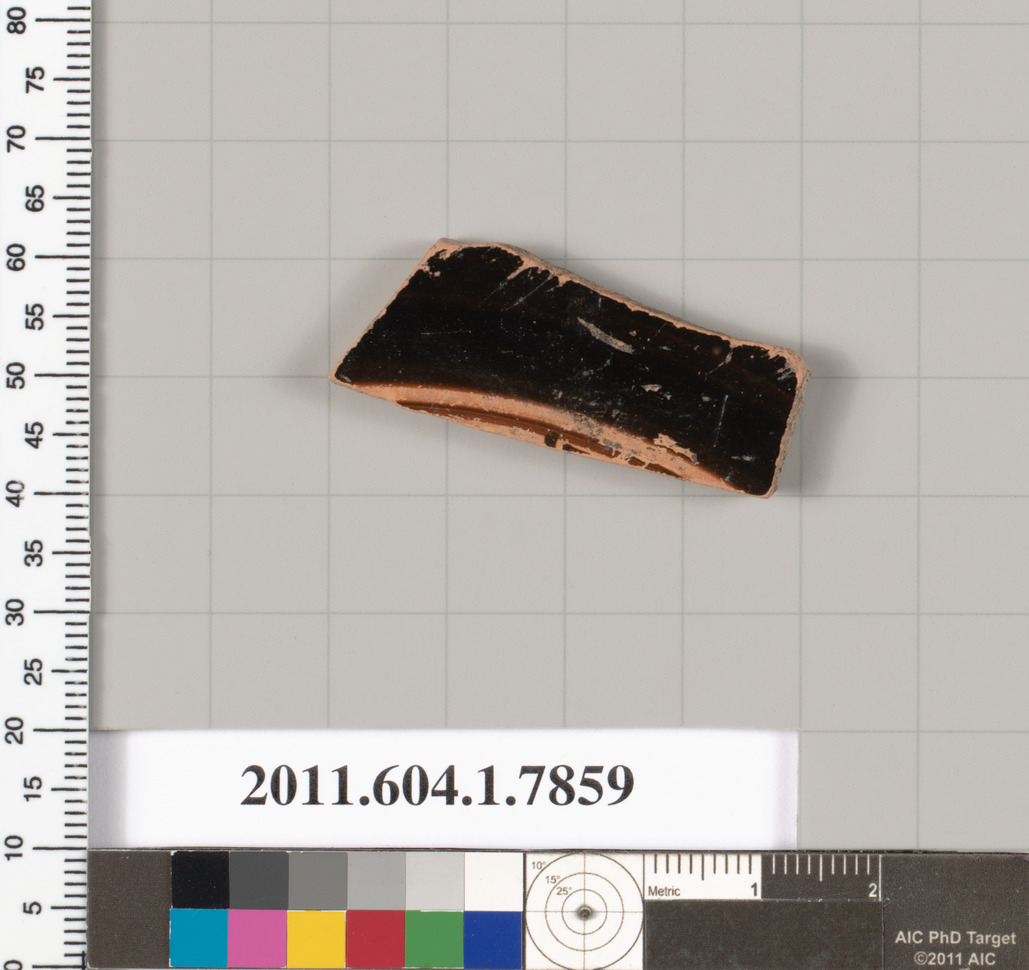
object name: kylix fragment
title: Terracotta fragment of a kylix (drinking cup)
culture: greek, attic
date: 440-420 BCE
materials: terracotta